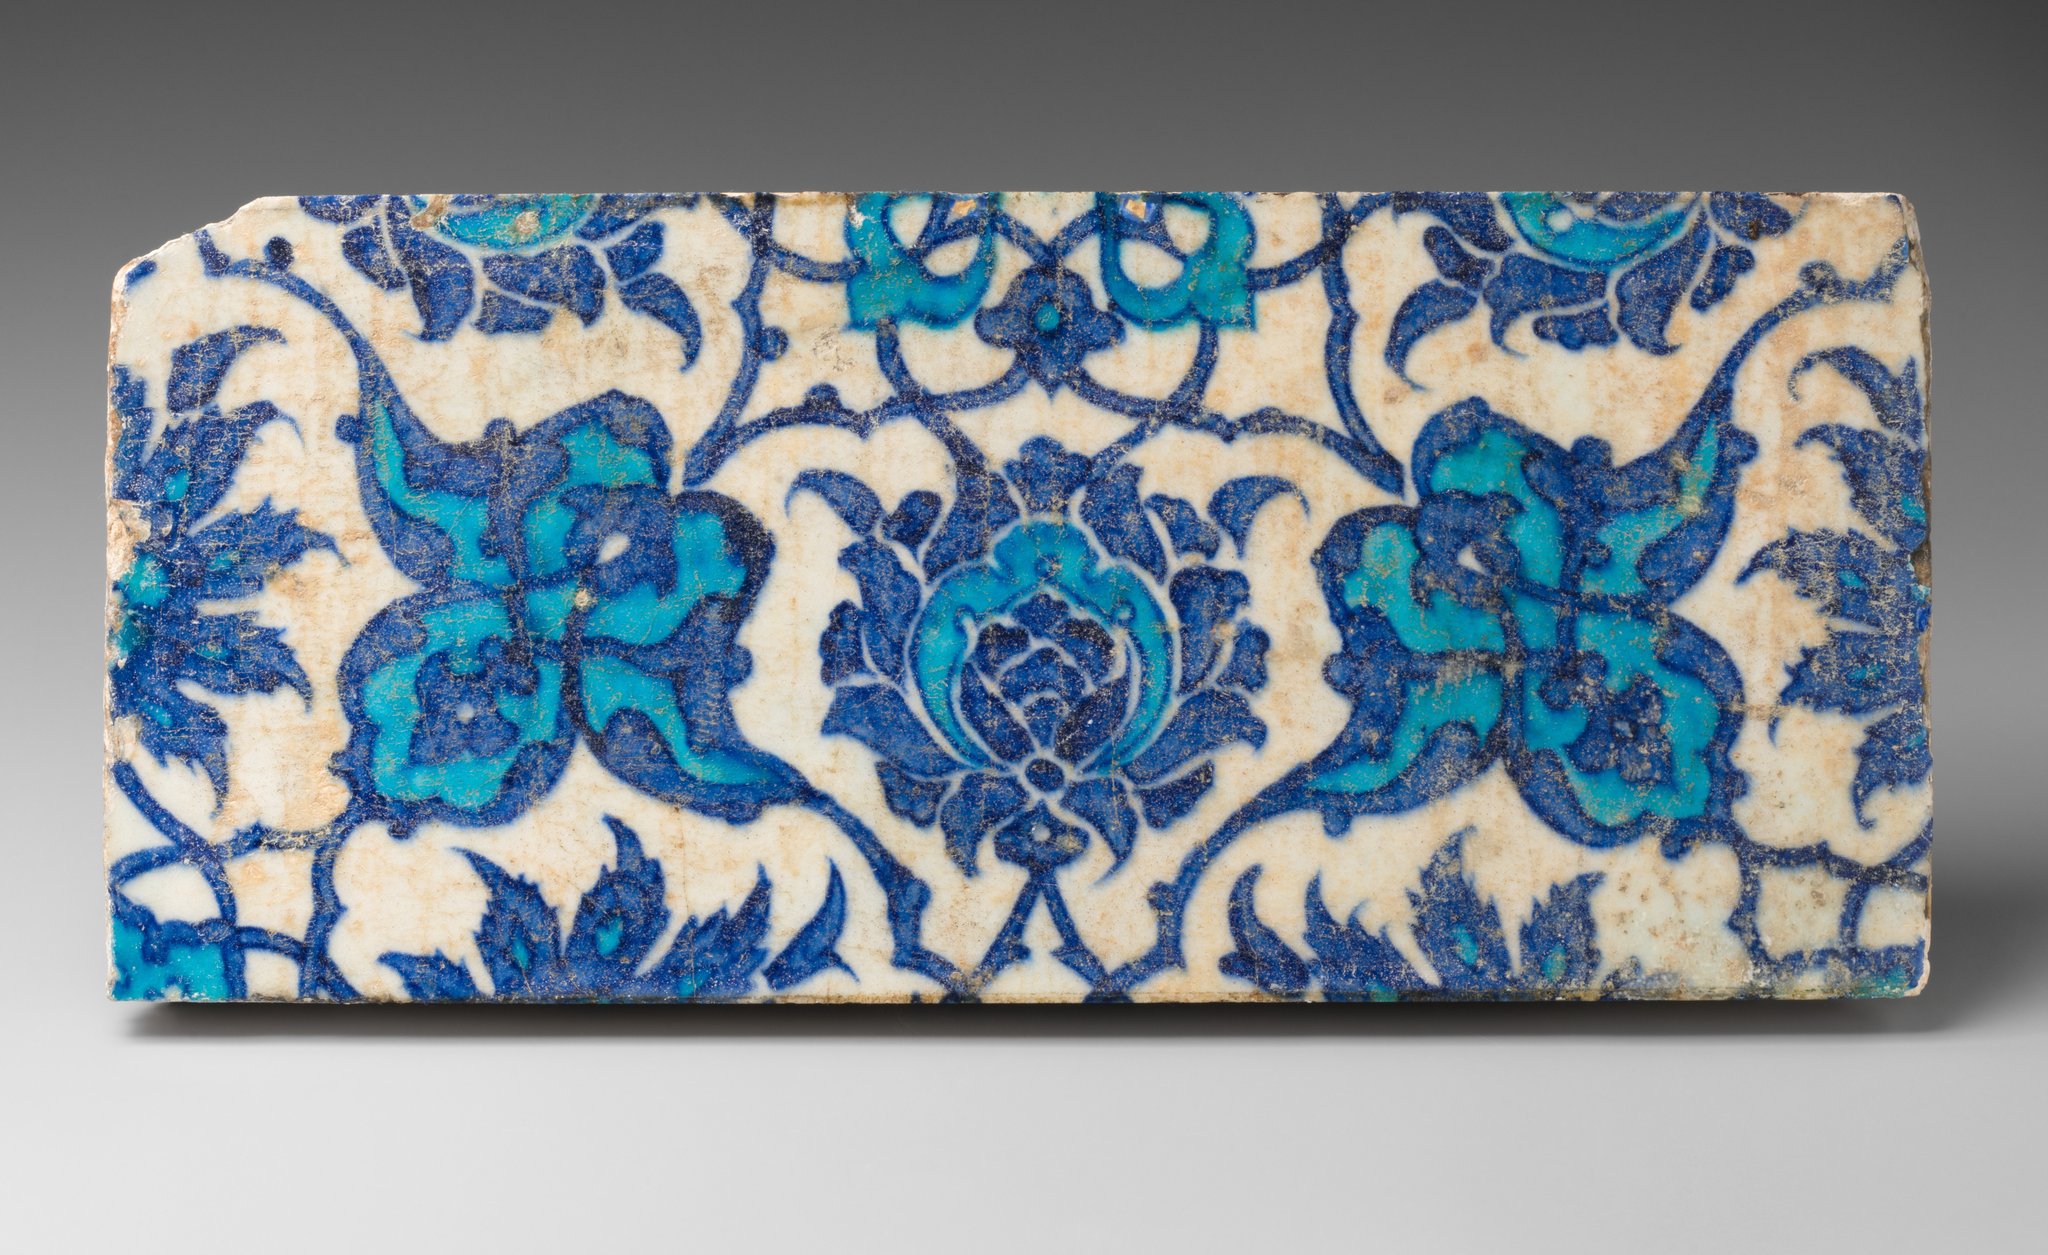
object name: tile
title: Tiles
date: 1551-1600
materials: stonepaste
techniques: glazing, painting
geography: syria